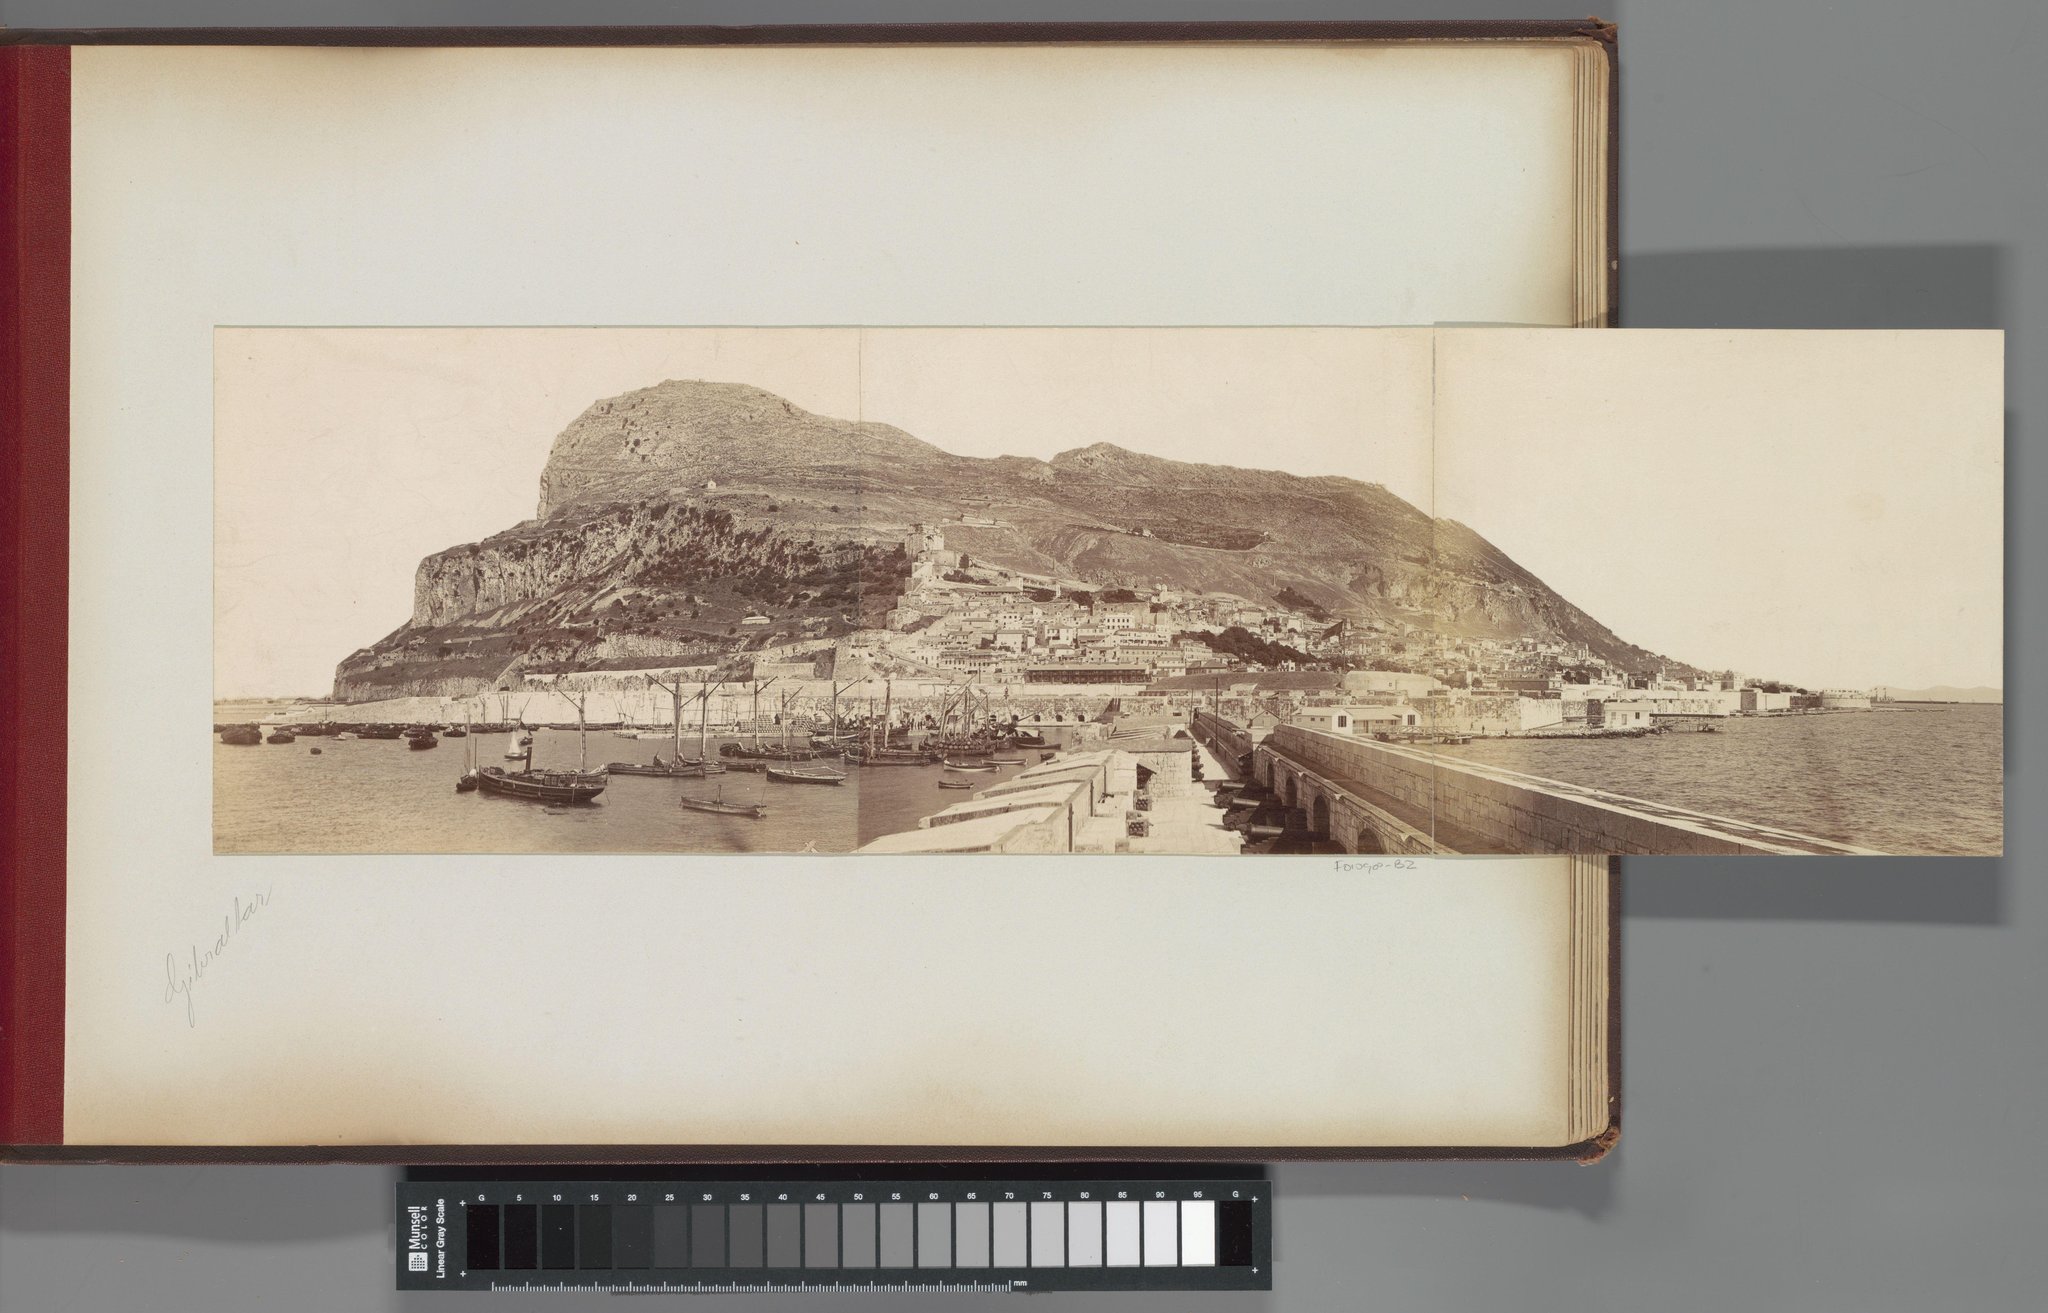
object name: panorama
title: Panorama van de Rots van Gibraltar gezien vanaf een pier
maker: Anonymous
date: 1860-1880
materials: cardboard, paper, photographic support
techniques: albumen print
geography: gibraltar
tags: rock-formations, prospect of city, town panorama, silhouette of city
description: Onderdeel van Reisalbum met foto's van bezienswaardigheden in Spanje en Marokko.